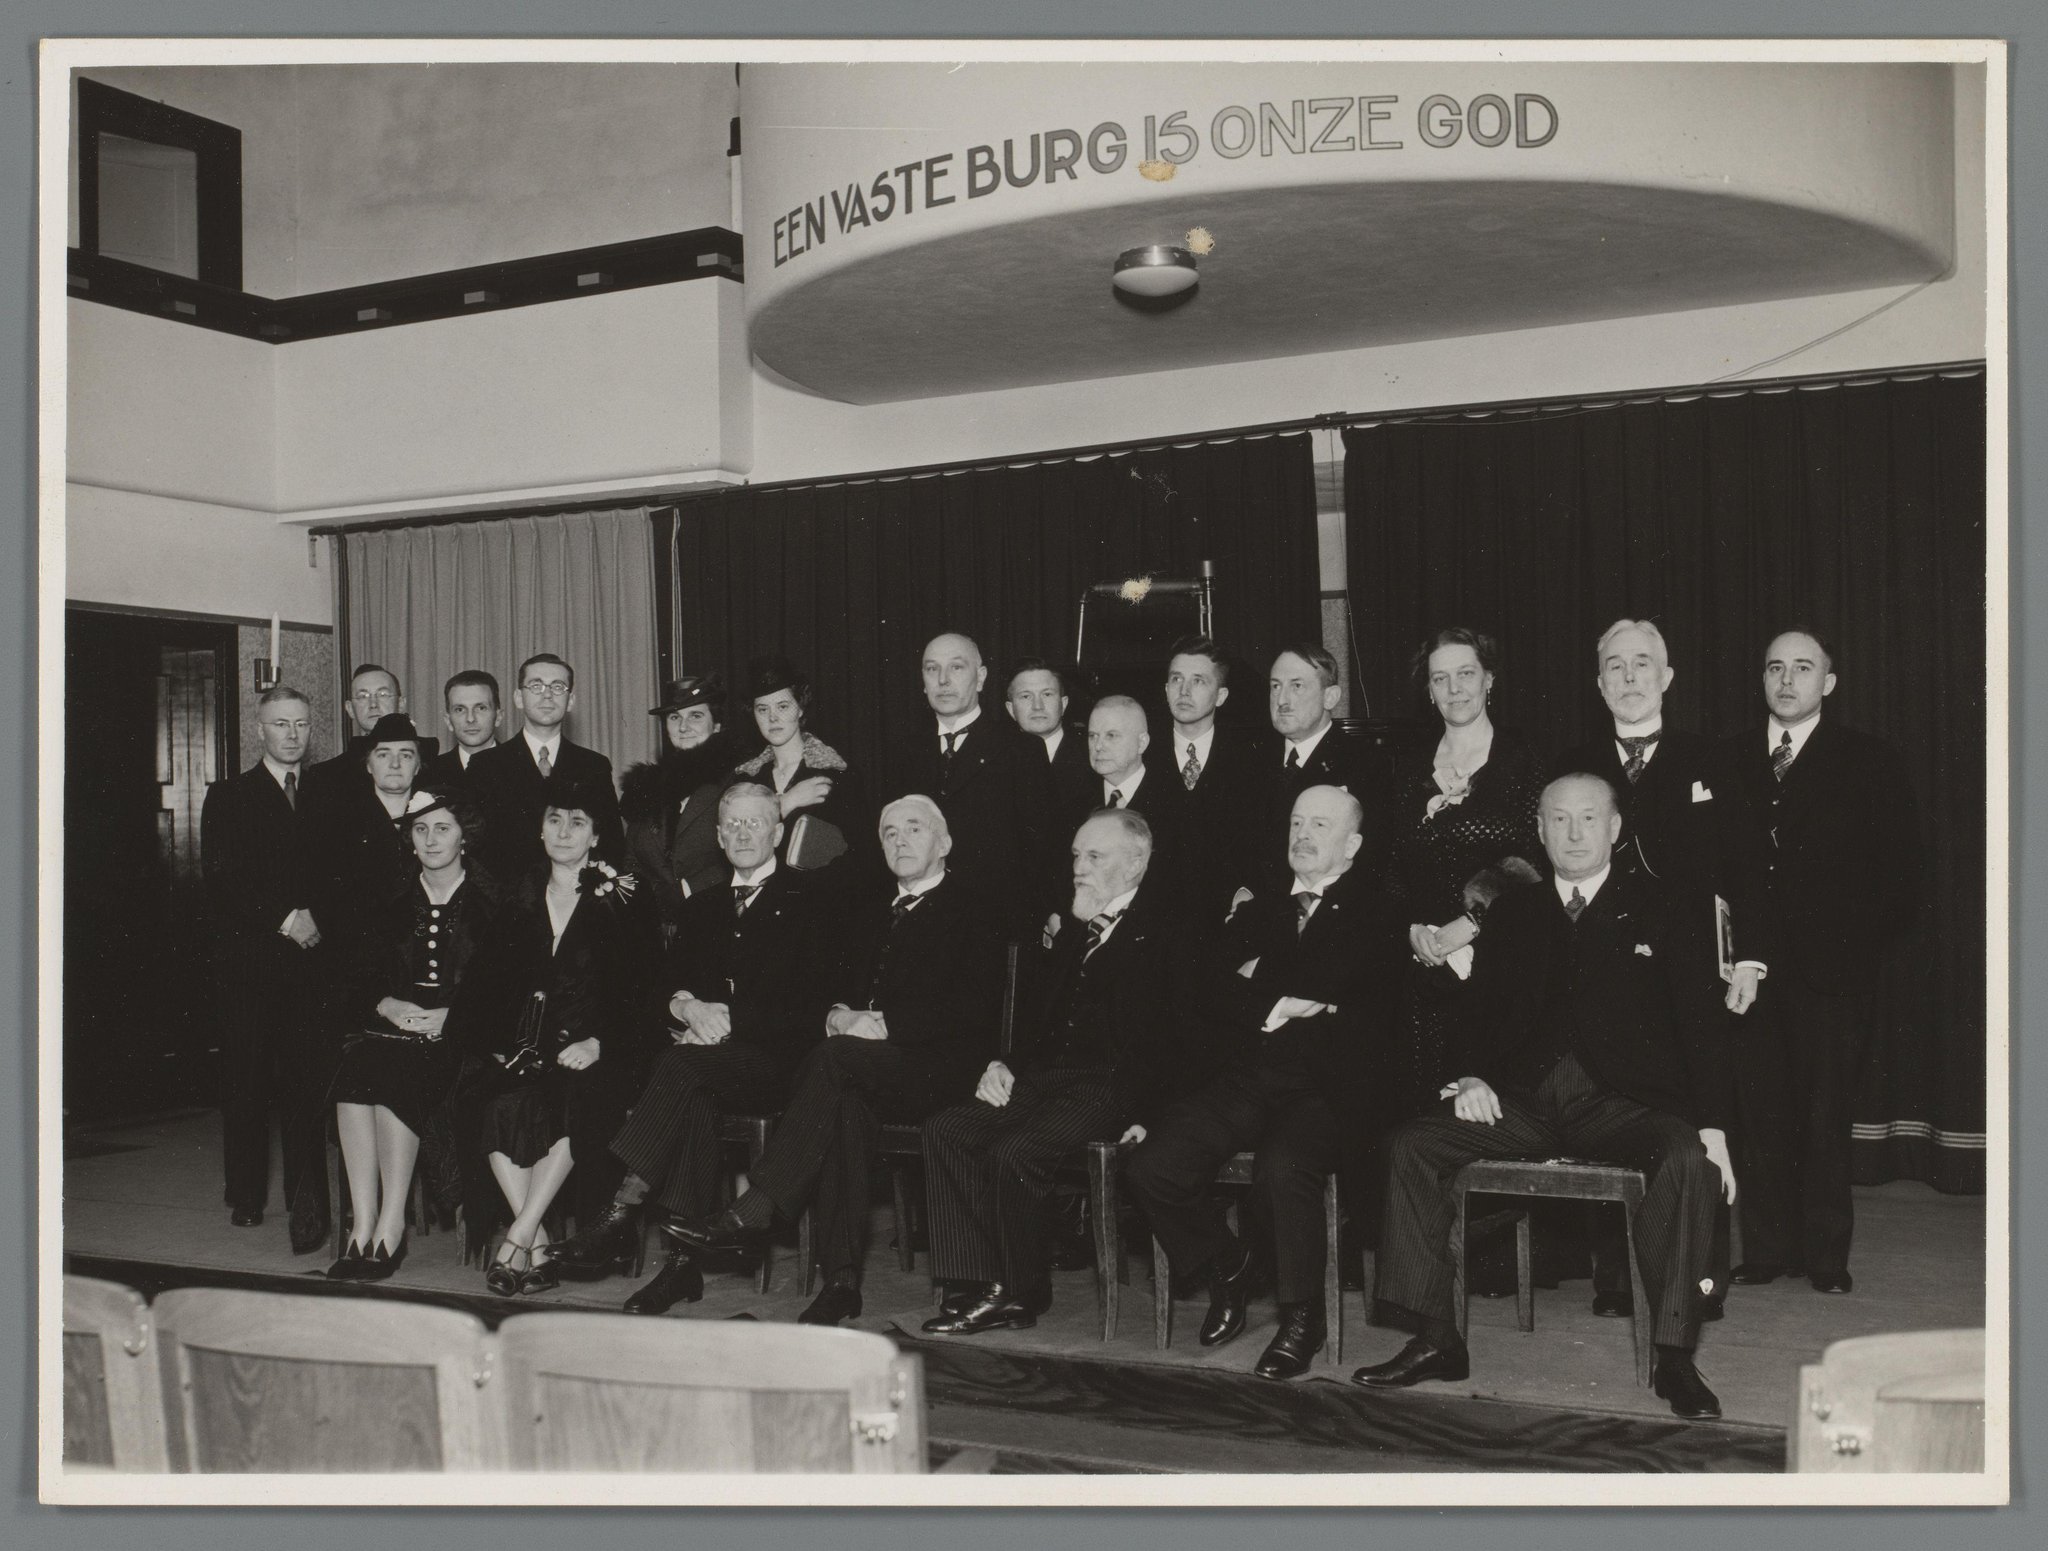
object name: photograph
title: Afscheid Dr W. Kolkert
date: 1939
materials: paper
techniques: gelatin silver print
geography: amsterdam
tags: amsterdam, the hague, deventer, abcoude, print maker, draughtsman, piet van wijngaerdt, historical persons, interior of church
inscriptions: inscription: ‘Zaterdagmiddag 30 Sept '39/ Lutherkapel./ Euterpestraat./ Afscheid Dr. W. Kolkert (...) Collega Warmink.’, stamp: ‘Copyright No./ Pers-foto-bureau "H.E.N.O."/ E.J. Noordhoff/ Voor [...] onzer [...] in welken/ [...[ recht verschuldigd./ Pl. Middenlaan 35, Tel. 55858, Amsterdam (C)’